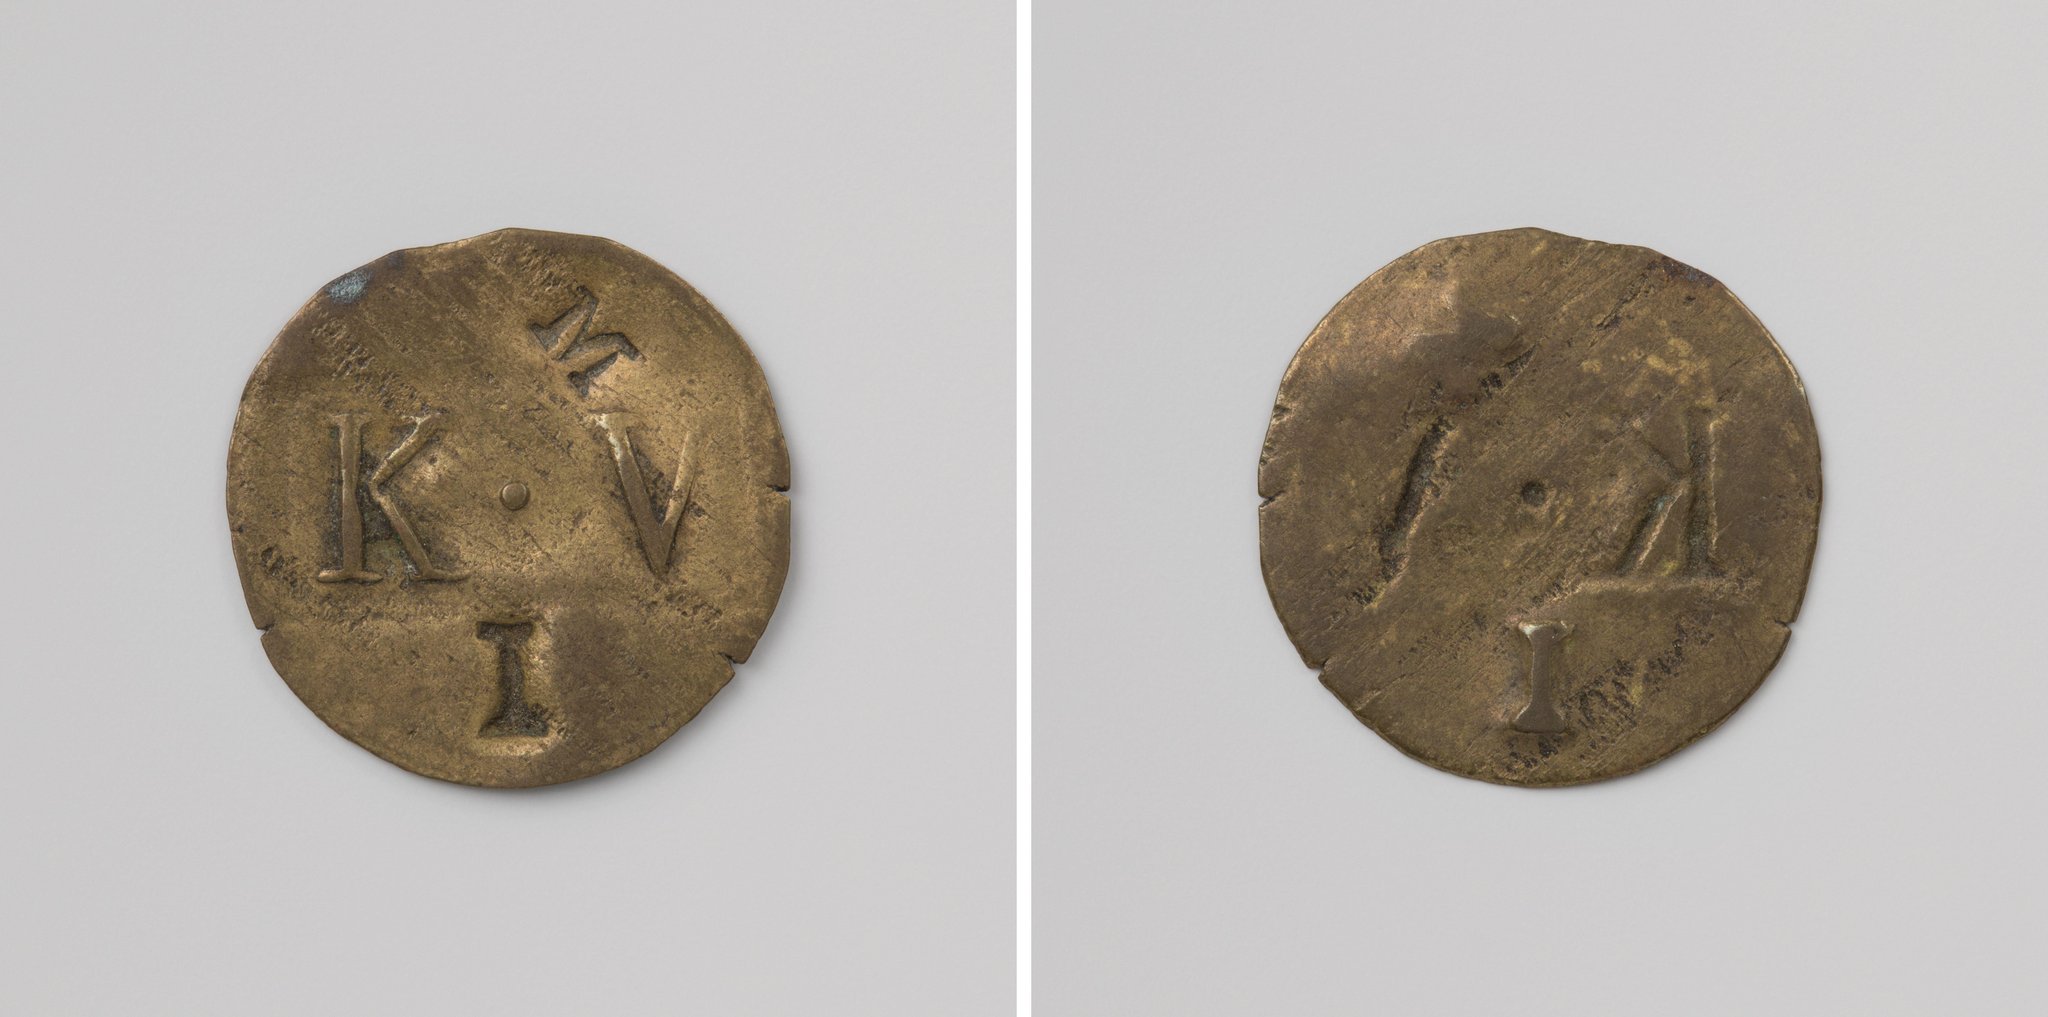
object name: huismunt prison money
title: Kolonie Veenhuizen, huismunt geslagen op last van de Maatschappij van Weldadigheid ter waarde van 1 cent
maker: Anonymous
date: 1818-1859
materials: brass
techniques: striking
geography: netherlands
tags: maatschappij van weldadigheid, veenhuizen